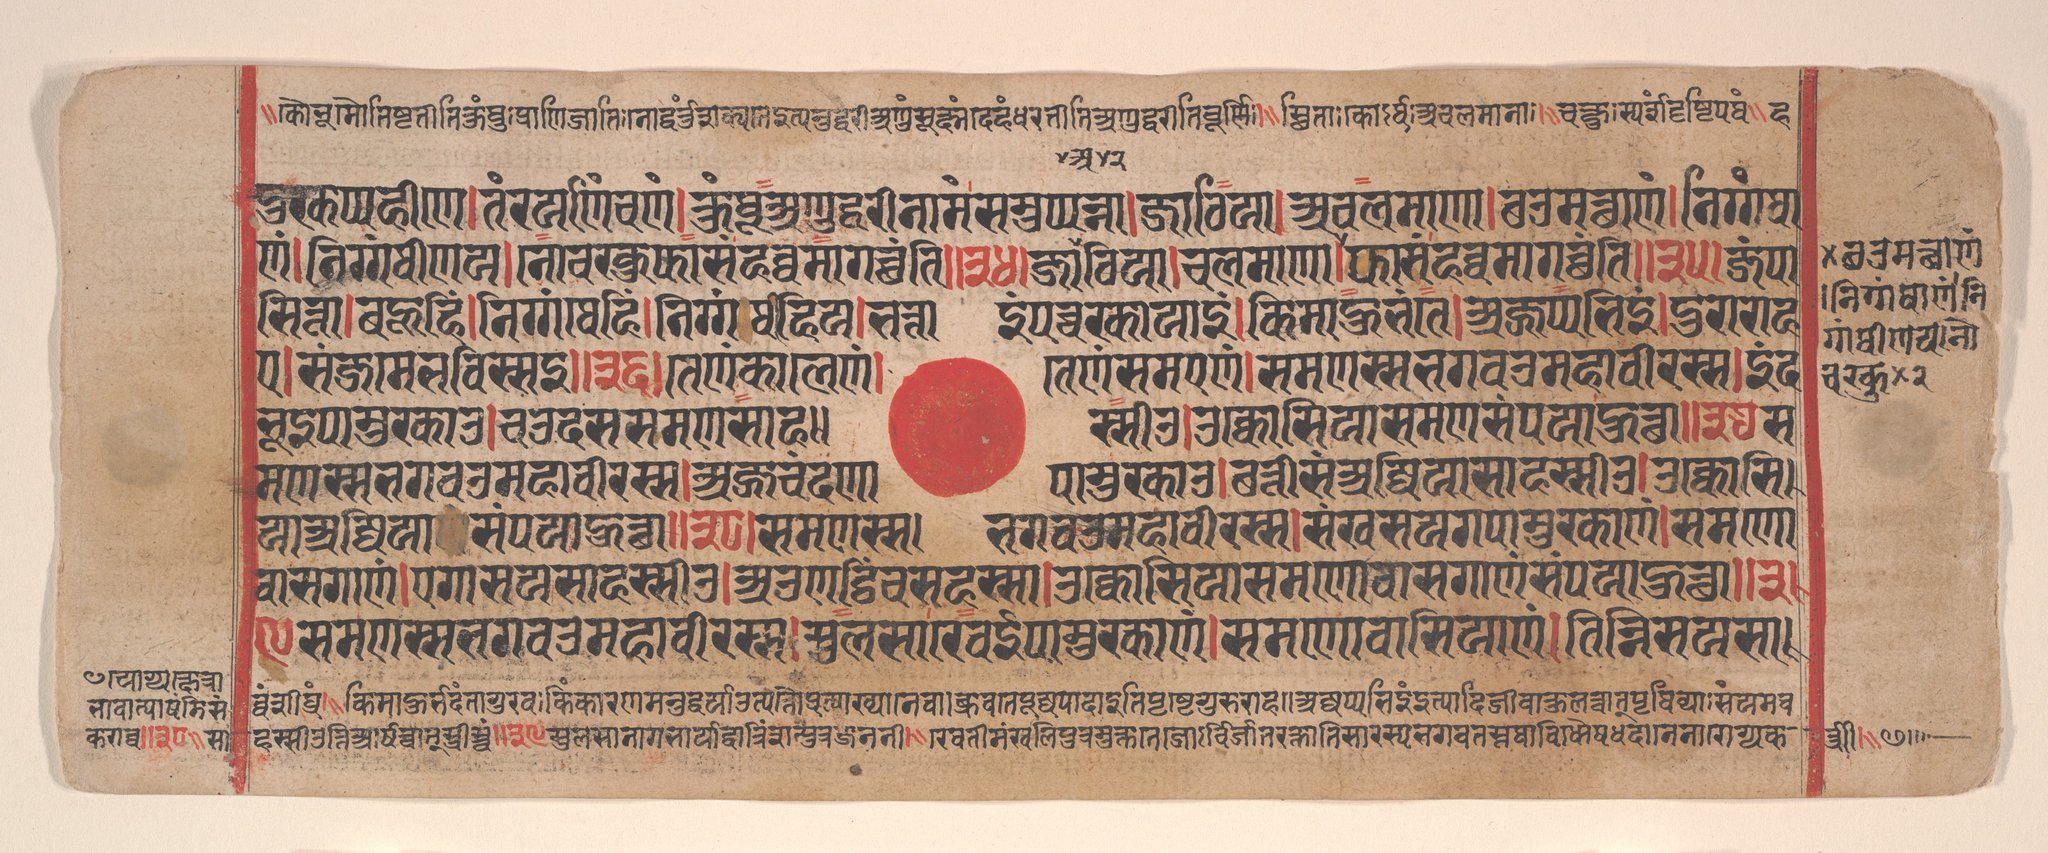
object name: folio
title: Leaf from a Kalpa Sutra (Jain Book of Rituals)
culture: indian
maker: bhadrabahu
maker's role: artist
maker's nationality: indian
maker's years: 356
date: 1401-1500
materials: gold, ink, paper, watercolor